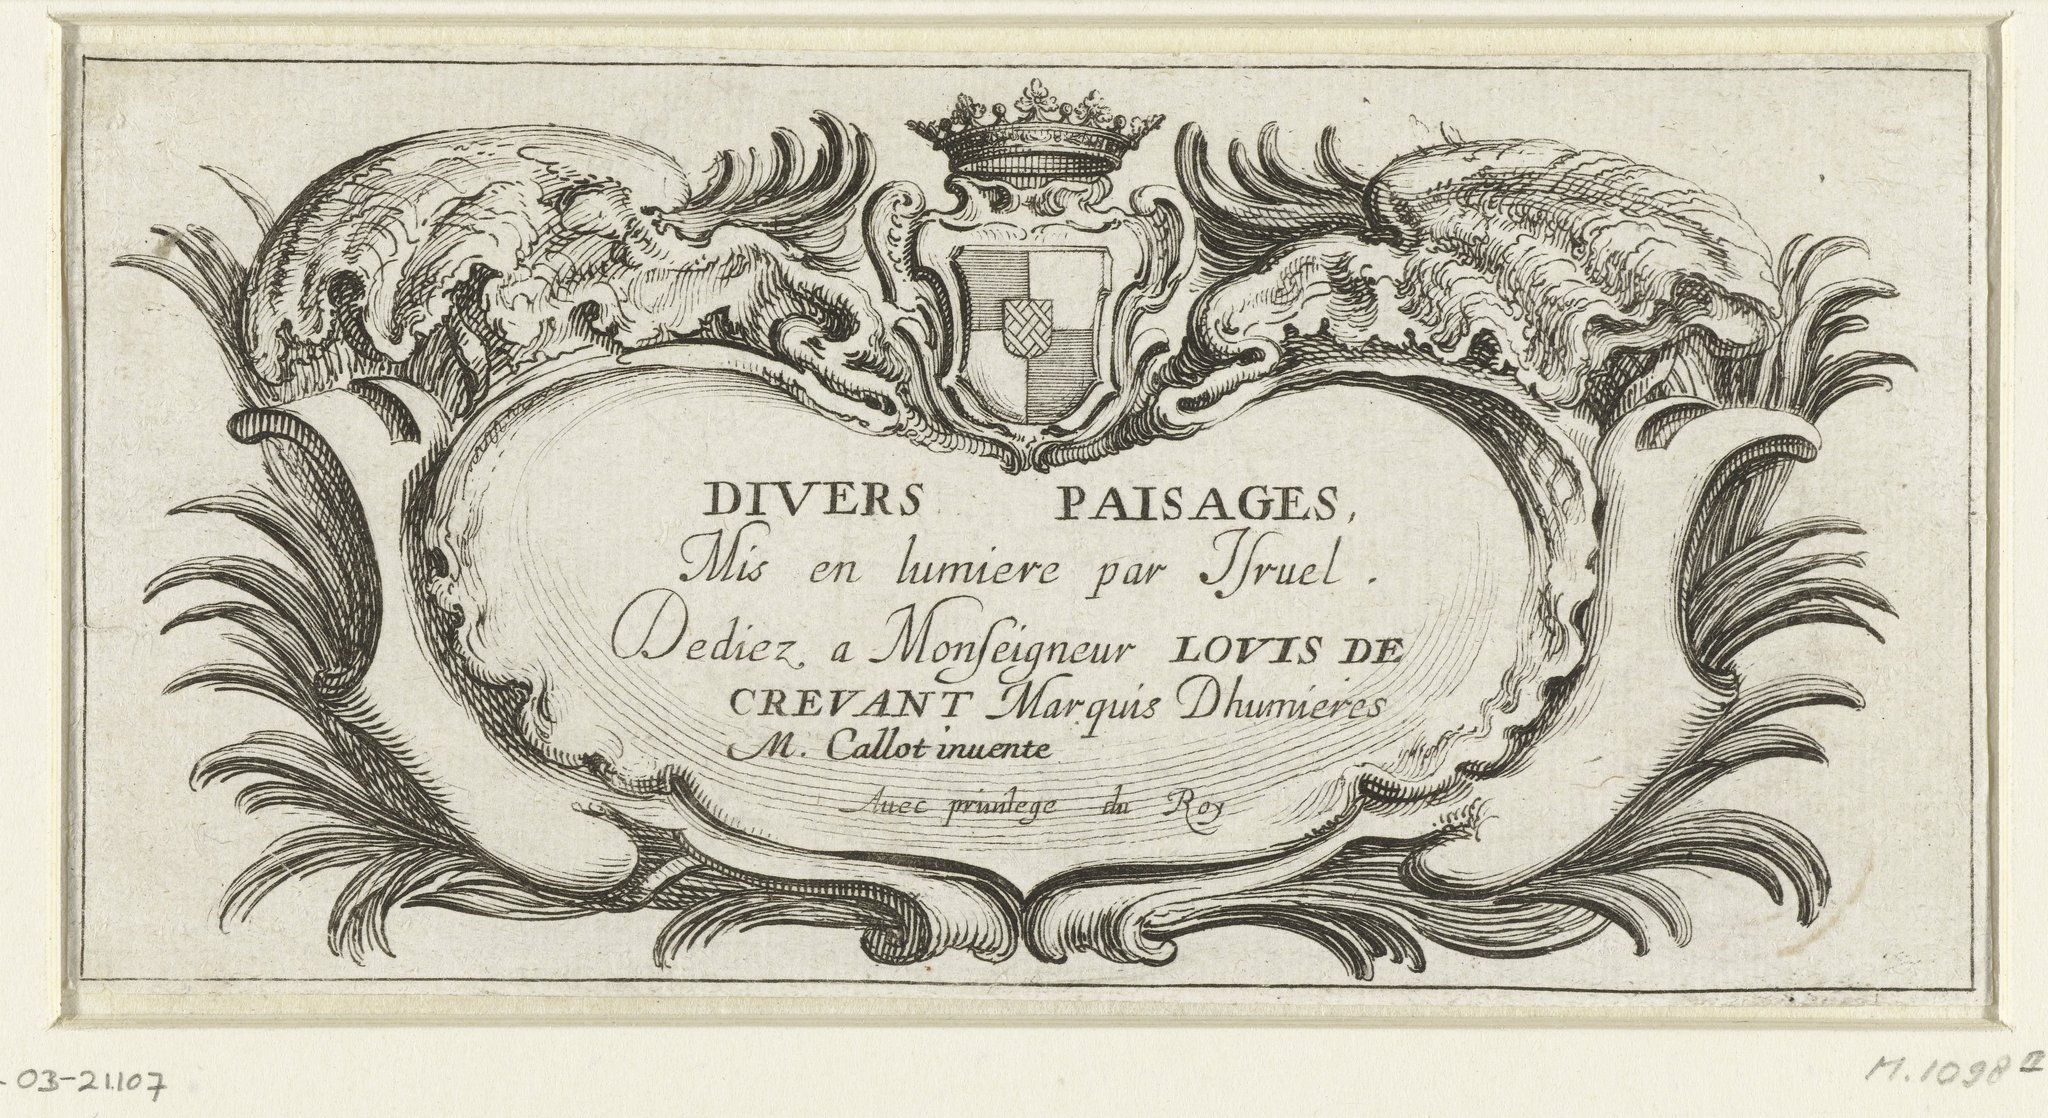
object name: titelprent, frontispice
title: Divers paisages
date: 1630-1660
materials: paper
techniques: etching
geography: paris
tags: louis de crévant (hertog van humières), ornament ~ cartouche, armorial bearing, heraldry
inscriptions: collector's mark: Lugt 240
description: Cartouche met Franse tekst, bekroond door wapenschild. Dit is de titelprent voor een serie van 19 prenten met landschappen.